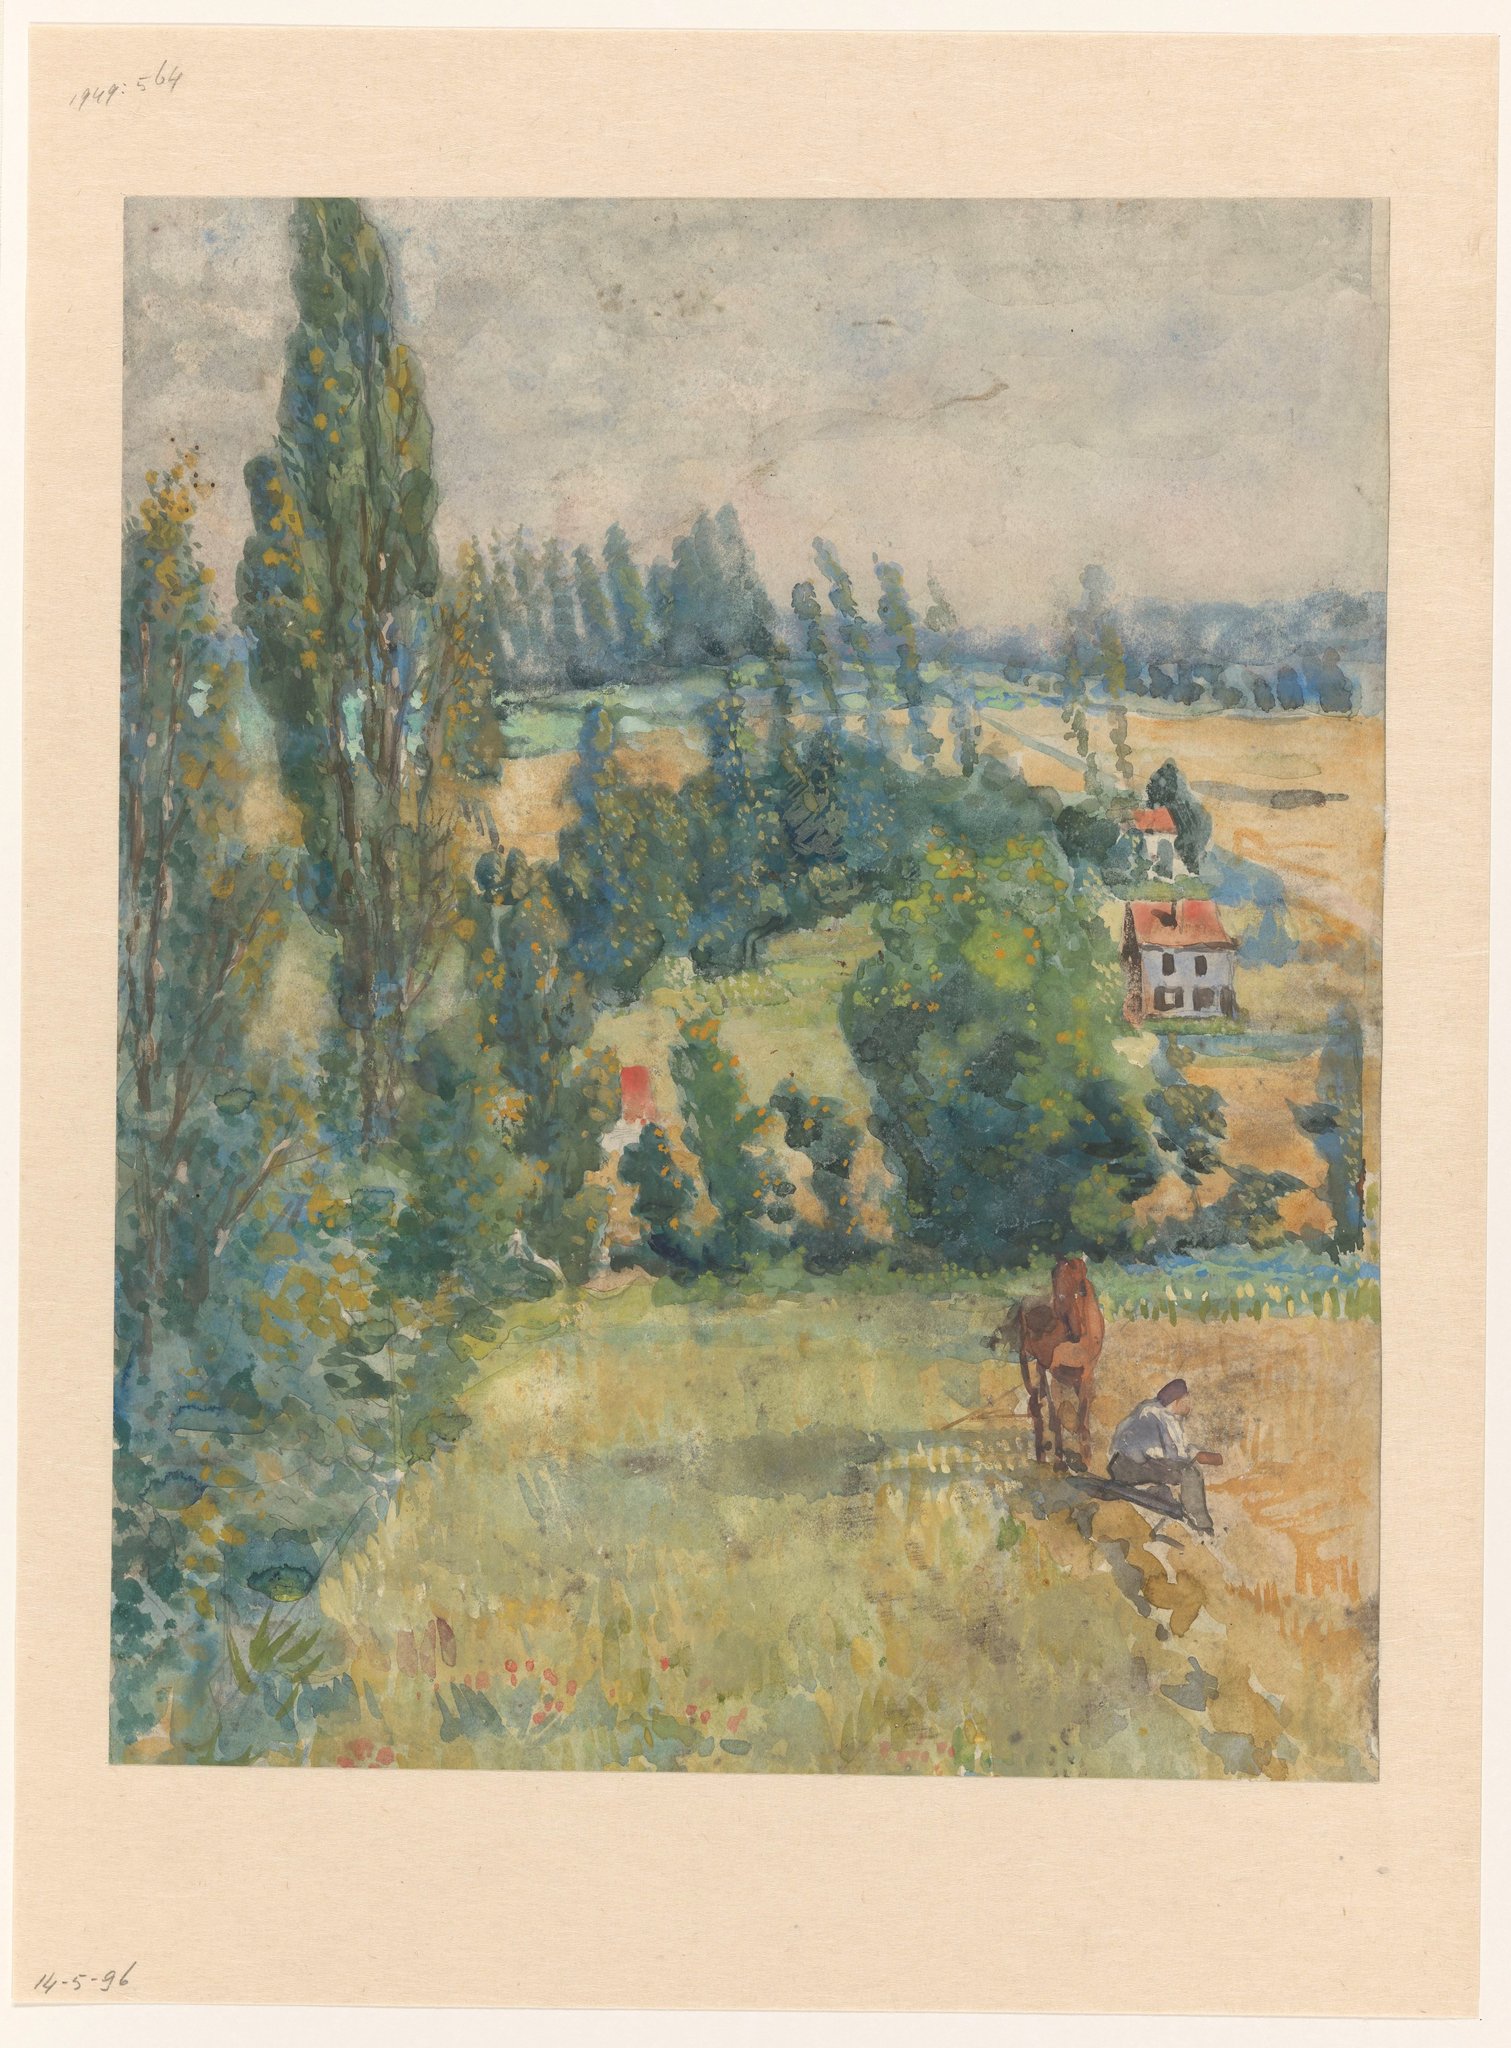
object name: drawing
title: Landschap met rustende boer bij een paard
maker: martinus van andringa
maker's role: draughtsman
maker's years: 1864-1918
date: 1874-1918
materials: paper, pencil, watercolor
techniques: brush